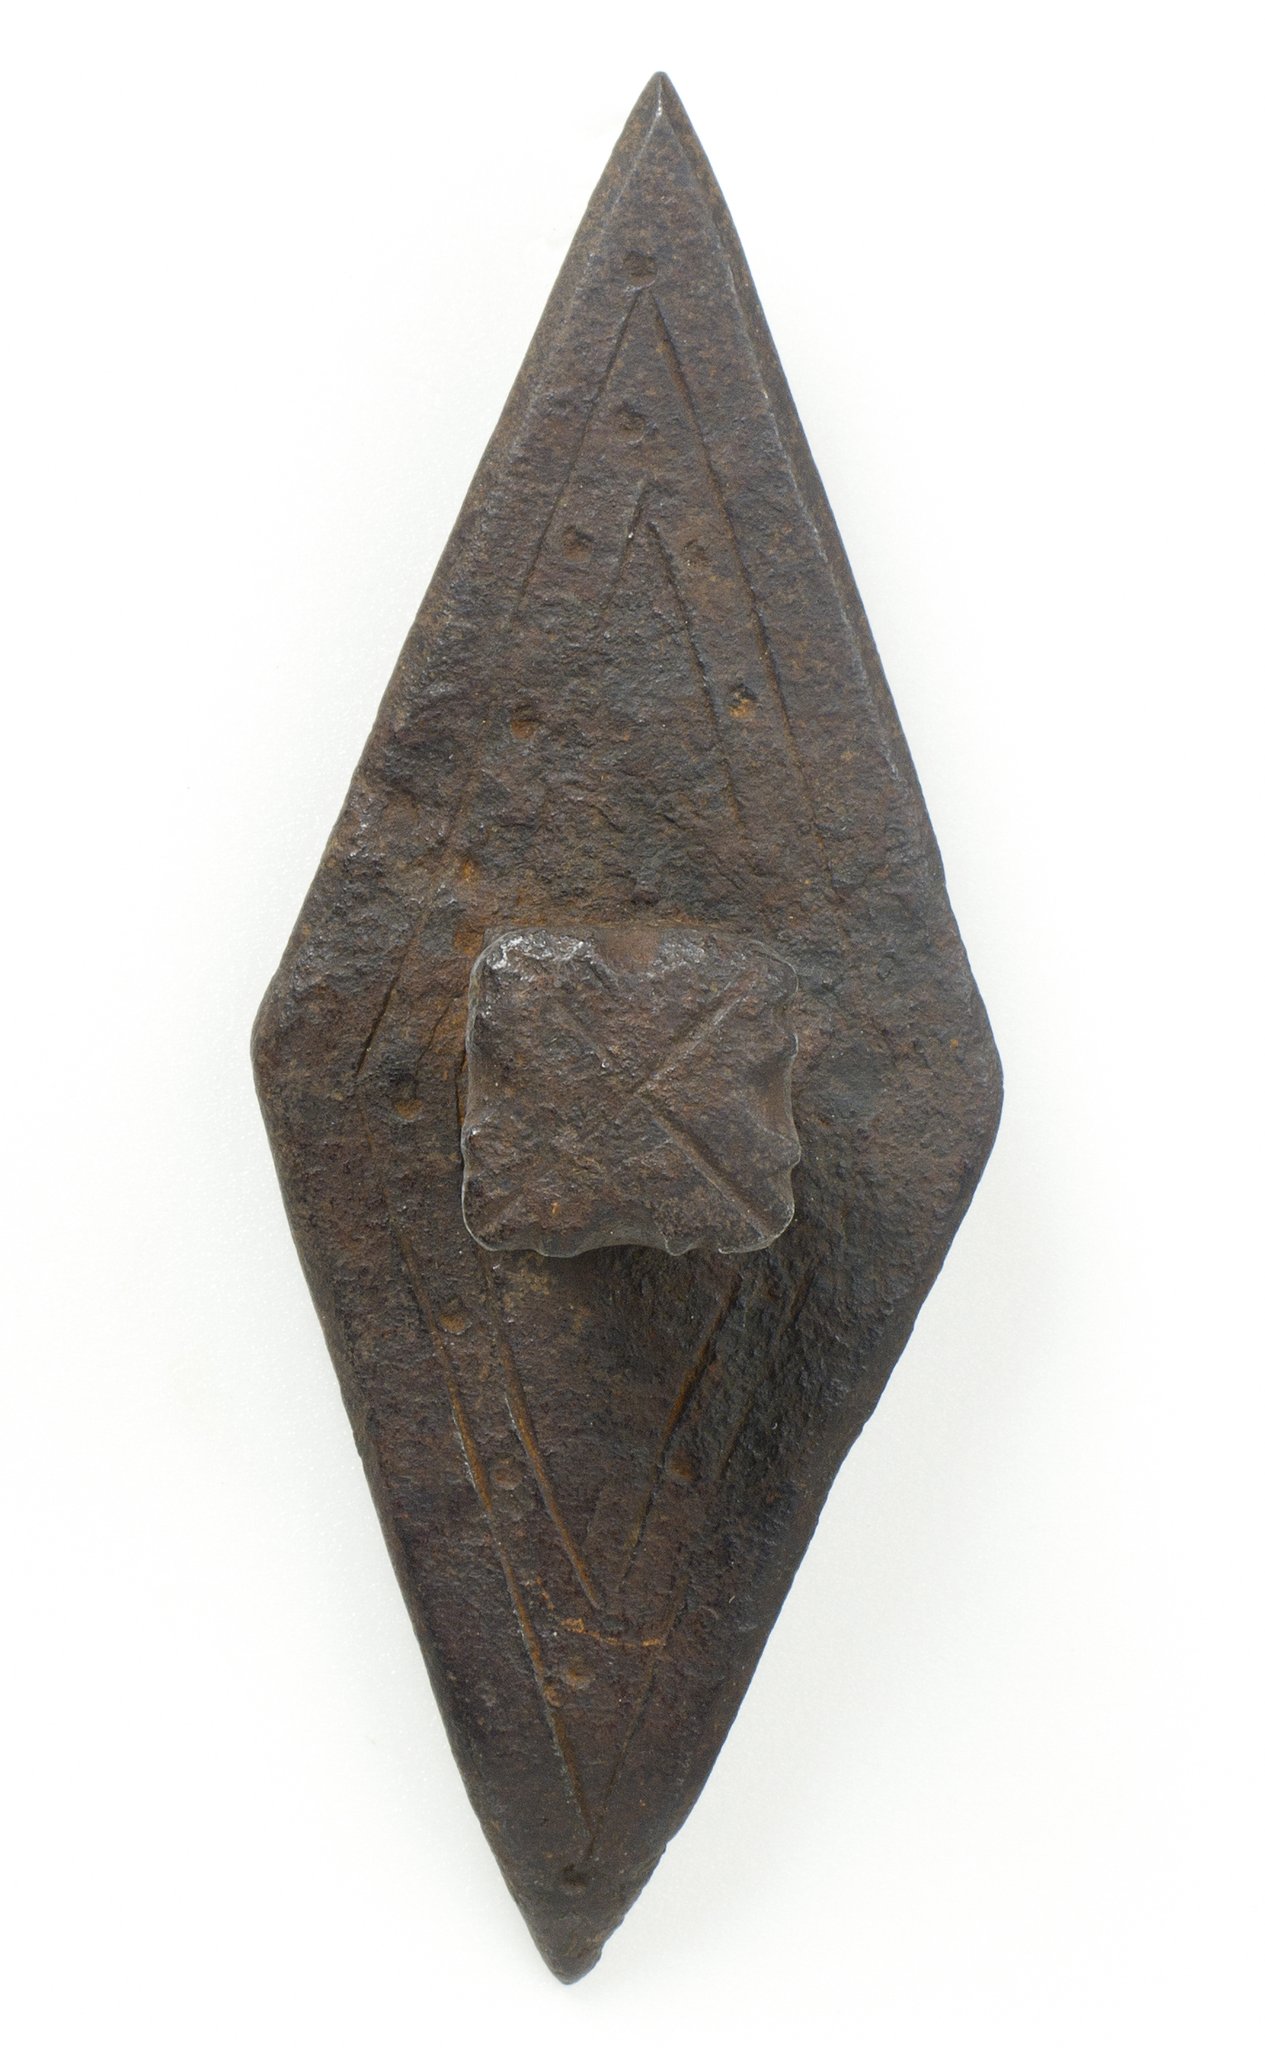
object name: plate and nail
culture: european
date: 1401-1600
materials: iron